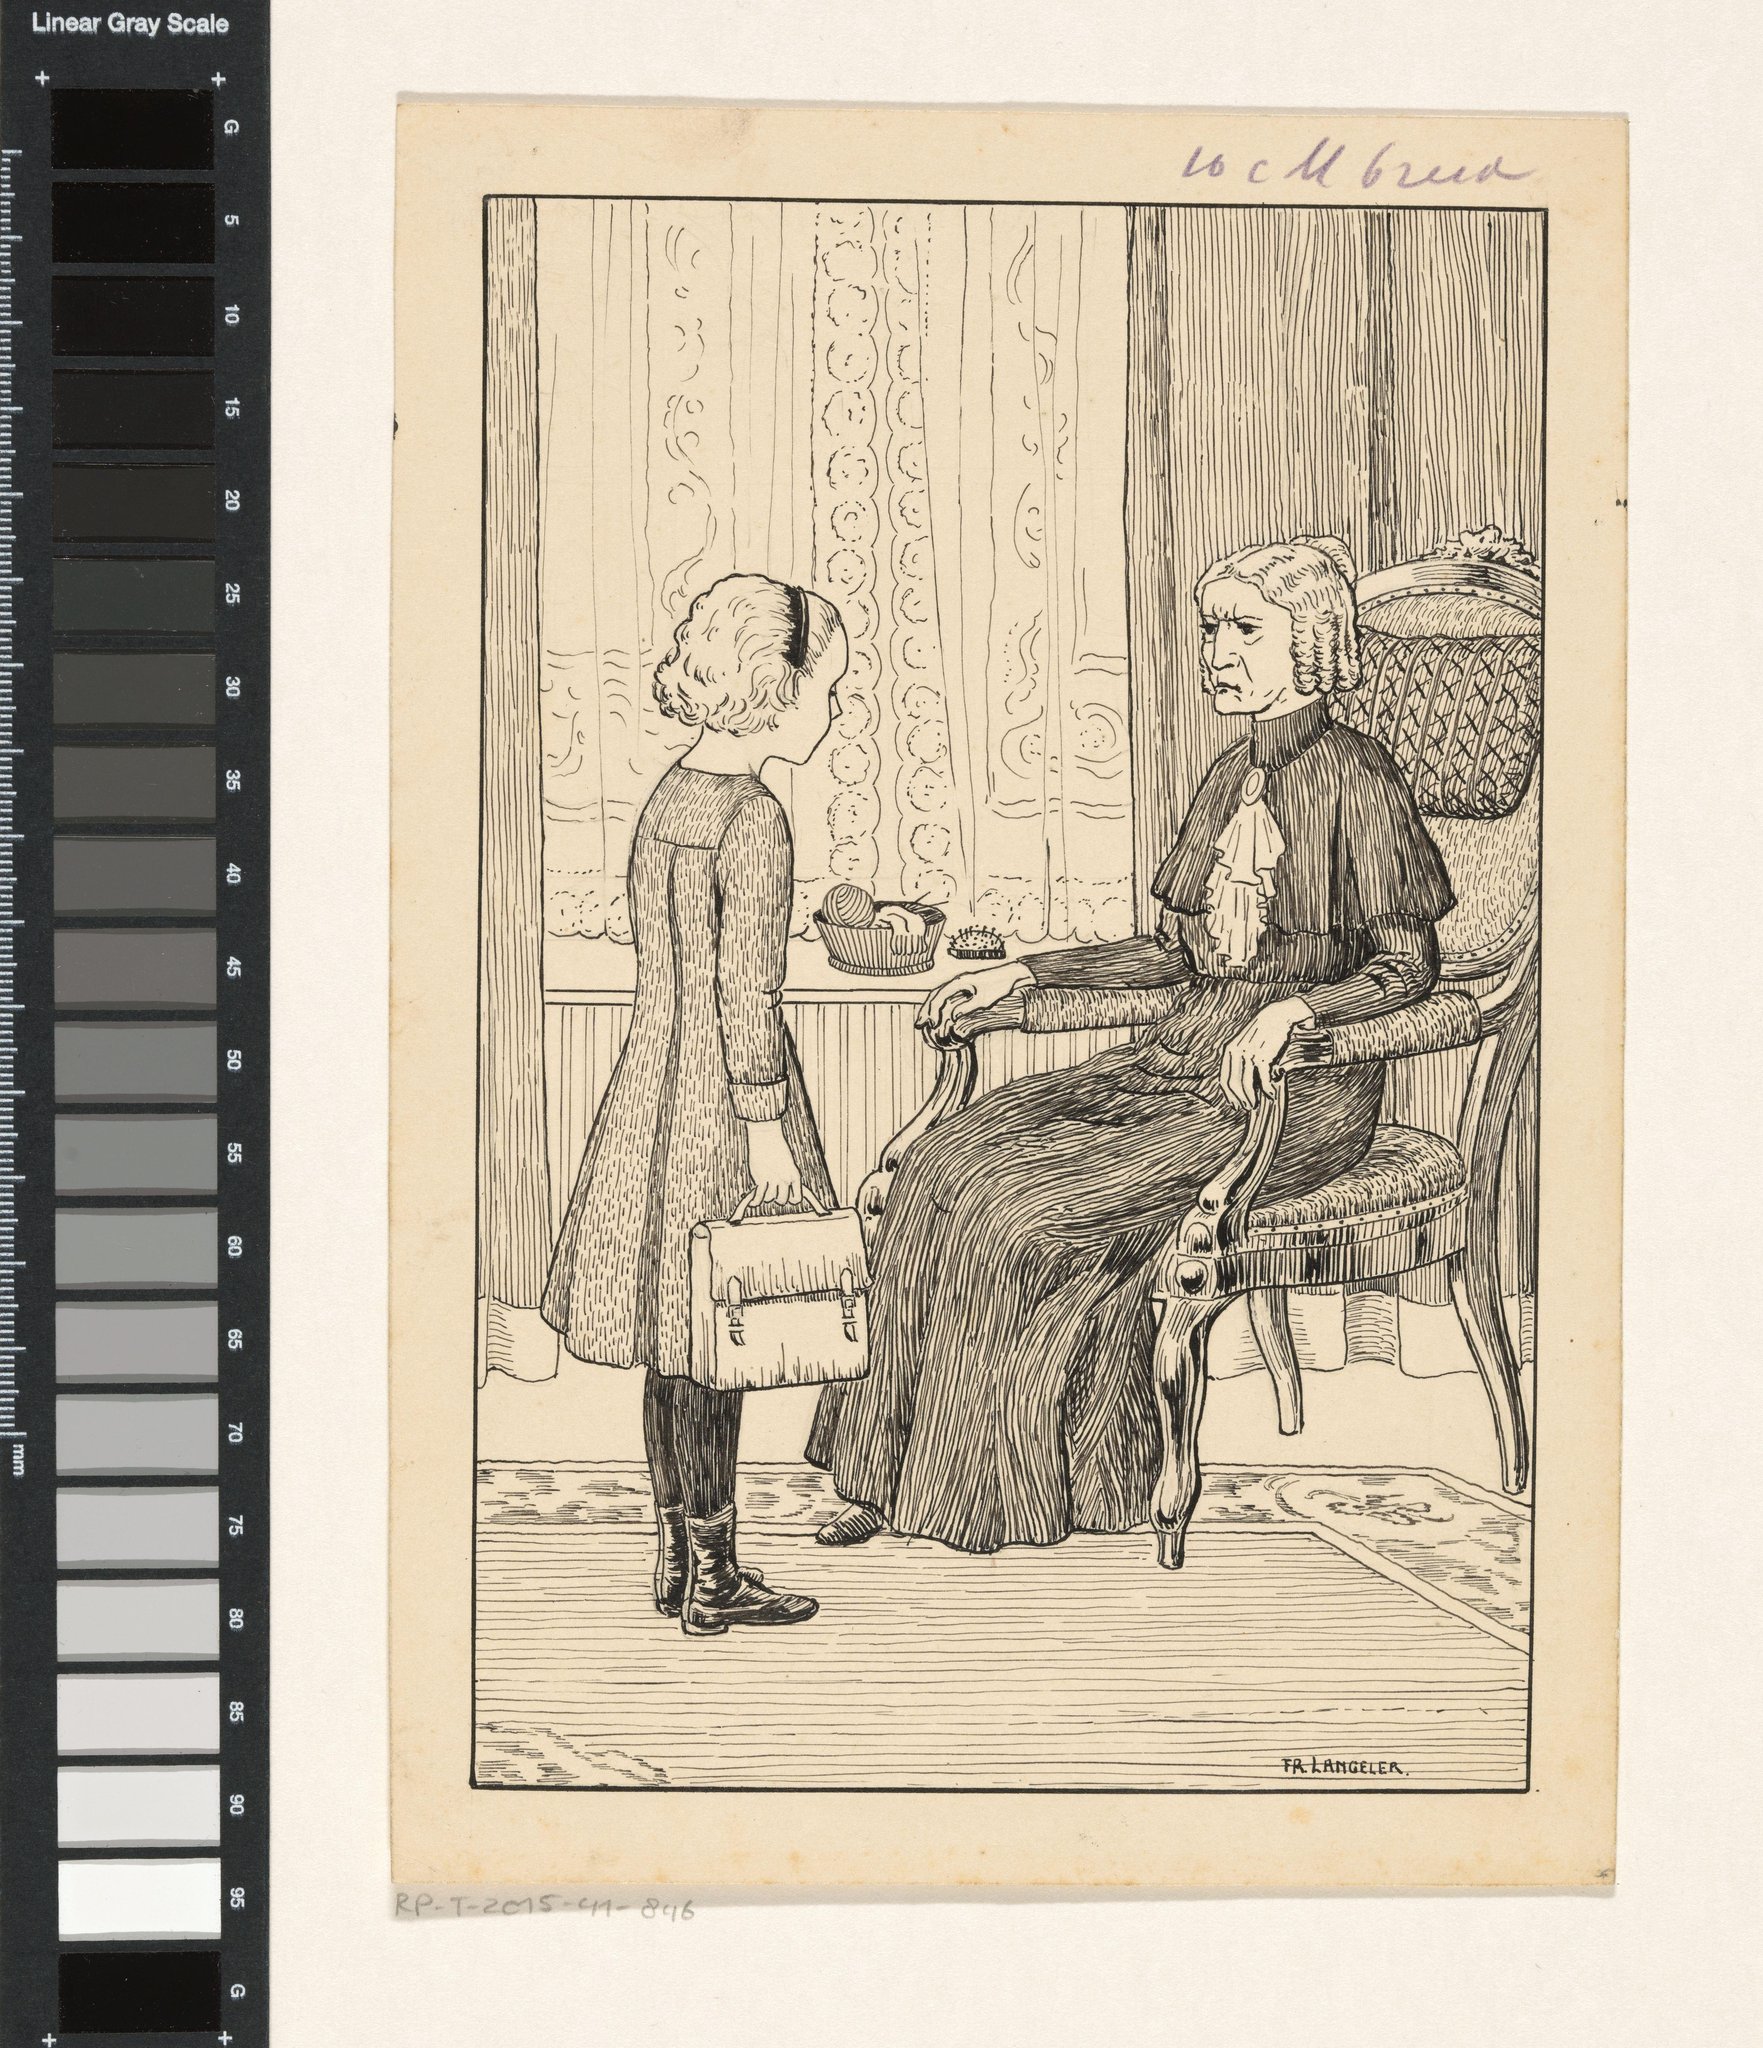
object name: boekillustratie ontwerp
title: Interieur met een meisje en oude vrouw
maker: freddie langeler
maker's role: draughtsman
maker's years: 1899-1948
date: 1909-1948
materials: ink, paper, pencil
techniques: pen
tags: sitting figure (+ old female (human being)), girl (child between toddler and youth), interior of the house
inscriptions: signature: ‘FR LANGELER.’, :, collector's mark: Lugt 2228, annotation: ‘blz. 37.’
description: Een oude vrouw zit in een leunstoel in een interieur. Voor haar staat een meisje met een schooltas in haar hand. In de vensterbank ligt breigerei.